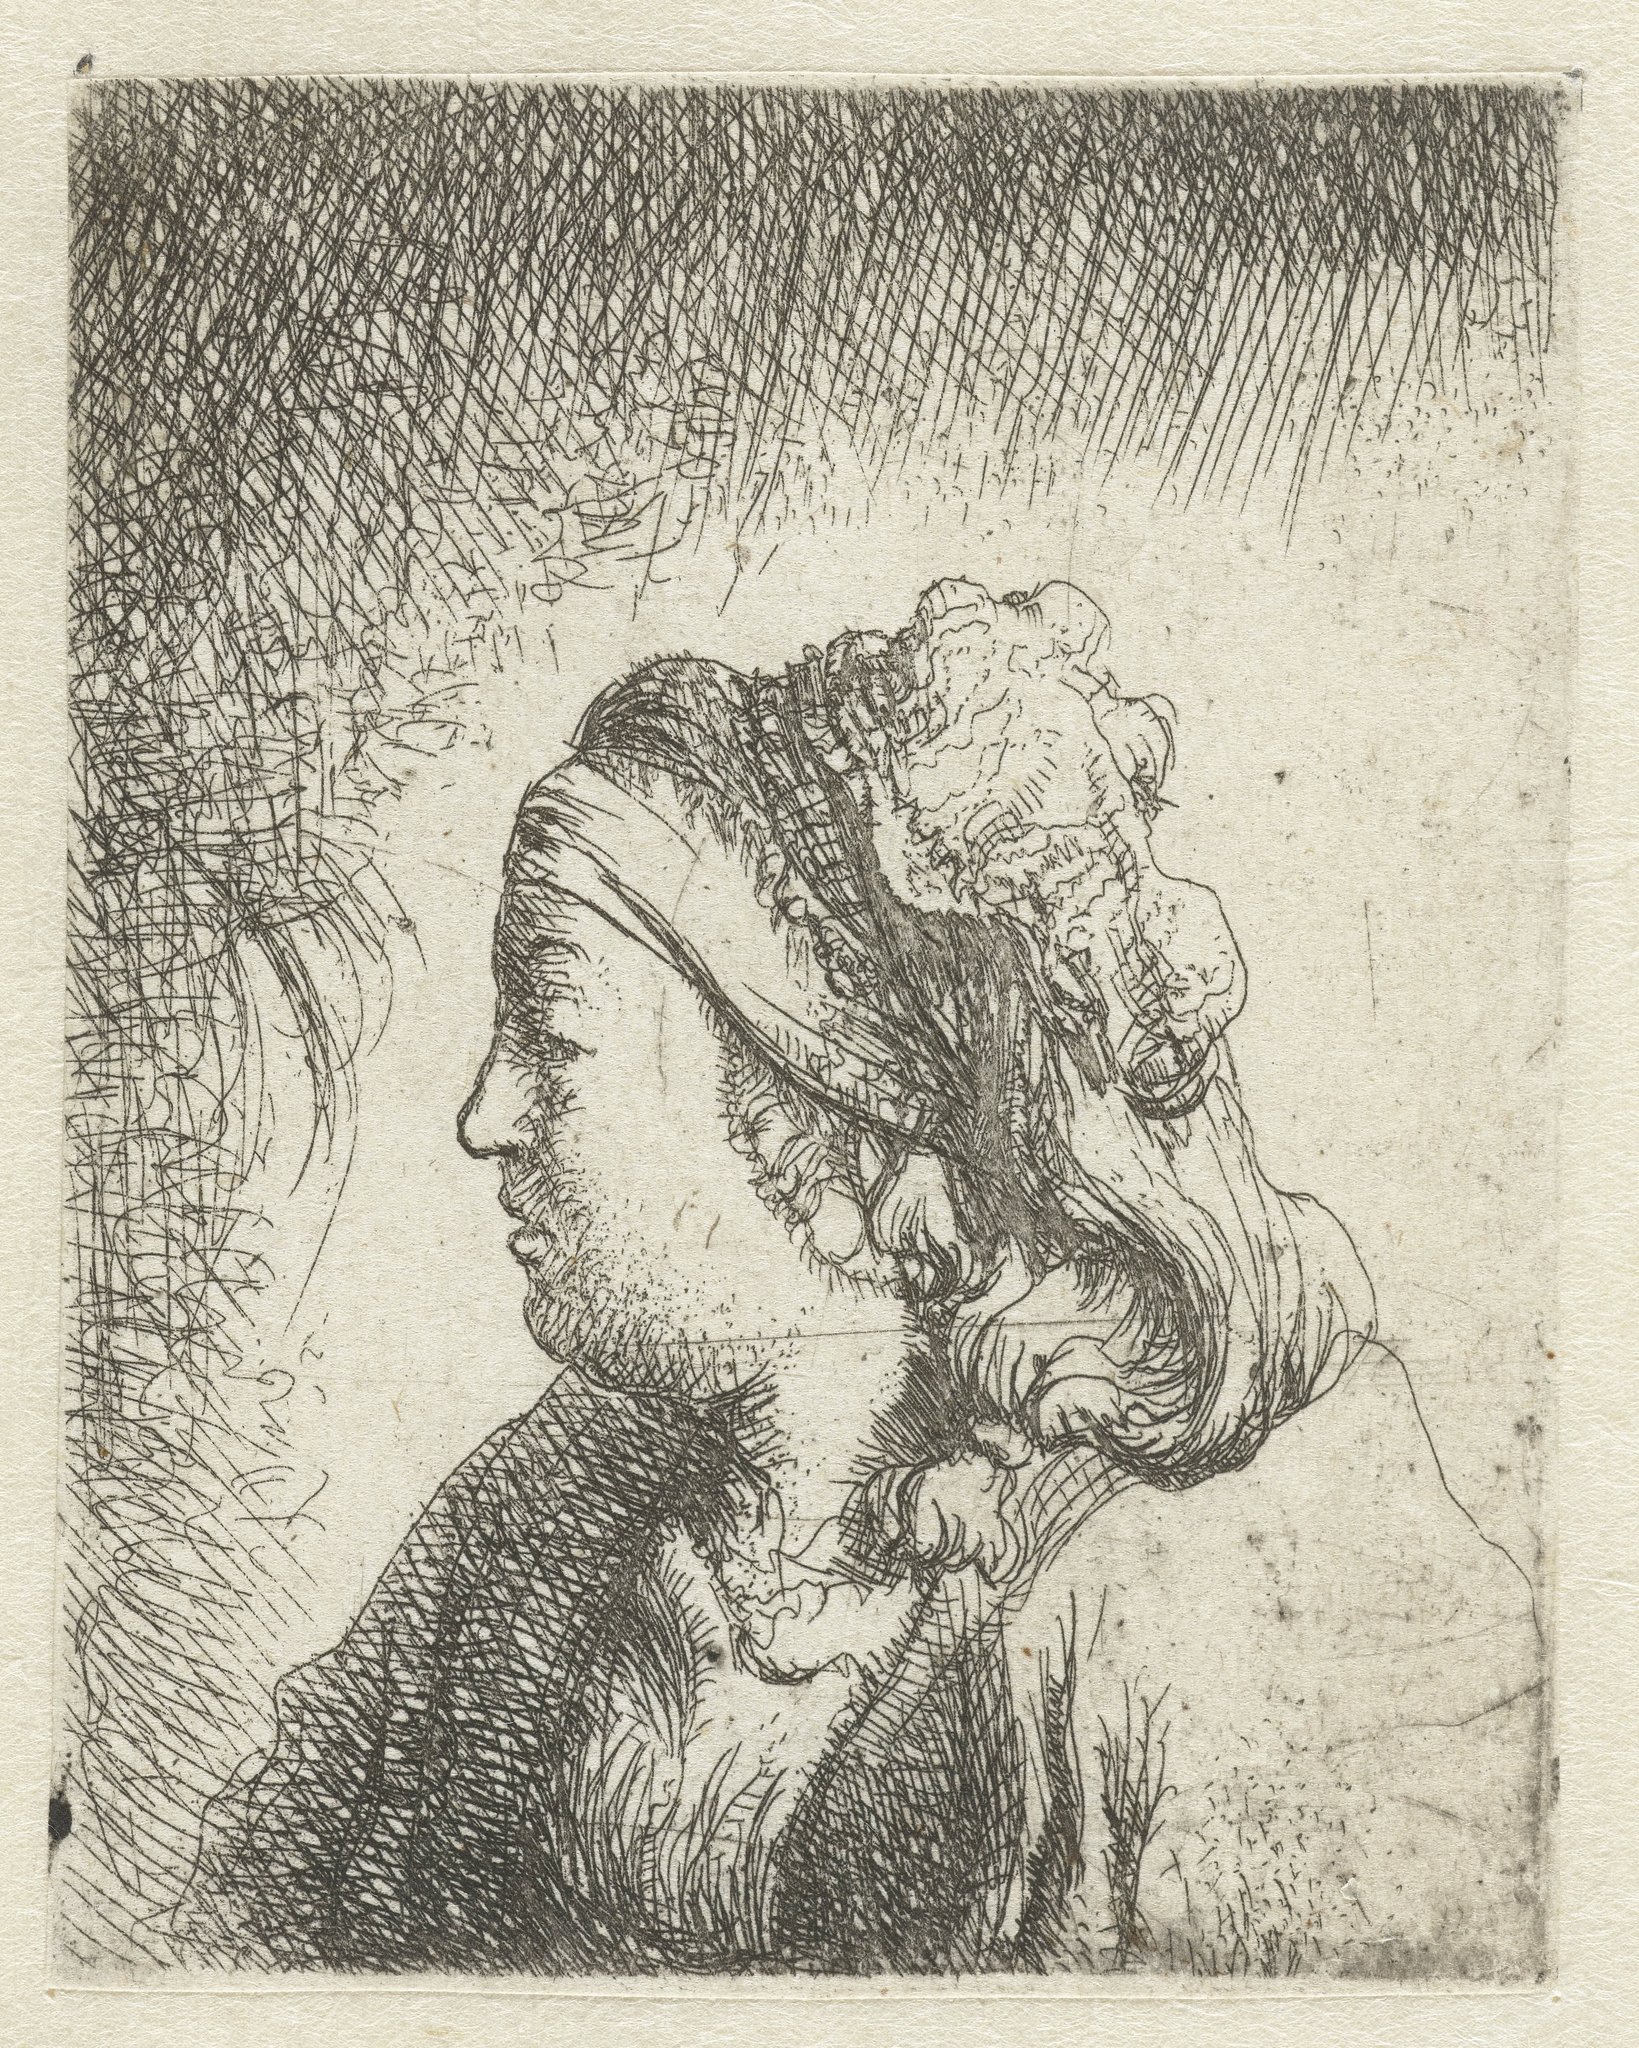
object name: print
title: Borstbeeld van een jonge vrouw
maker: jan lievens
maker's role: draughtsman, painter, print maker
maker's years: 1607-1674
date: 1625-1674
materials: paper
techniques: etching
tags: adolescent, young woman, maiden